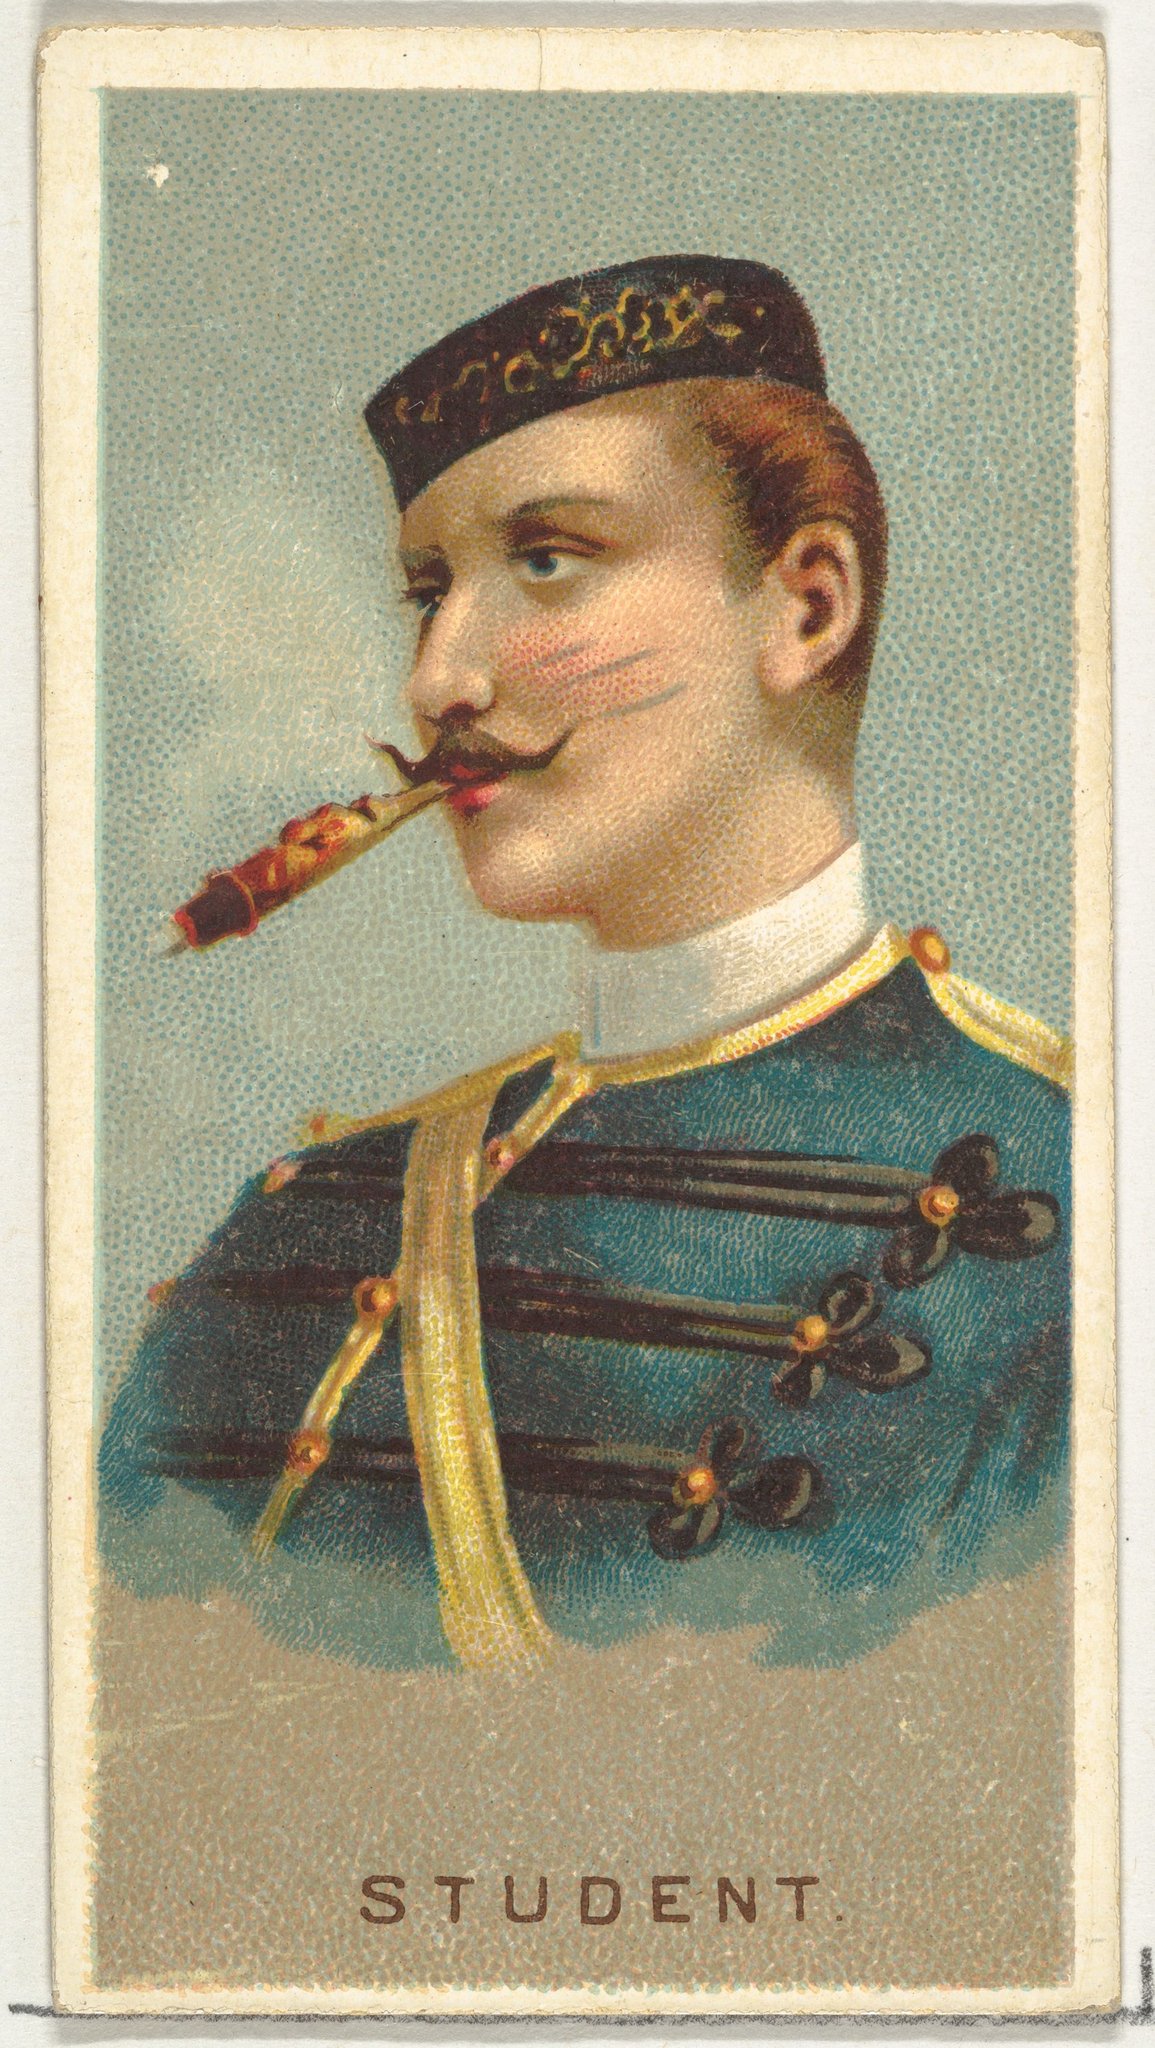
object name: print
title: Student, from World's Smokers series (N33) for Allen & Ginter Cigarettes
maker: allen & ginter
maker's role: publisher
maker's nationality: american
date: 1888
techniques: color lithograph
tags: men,smoking